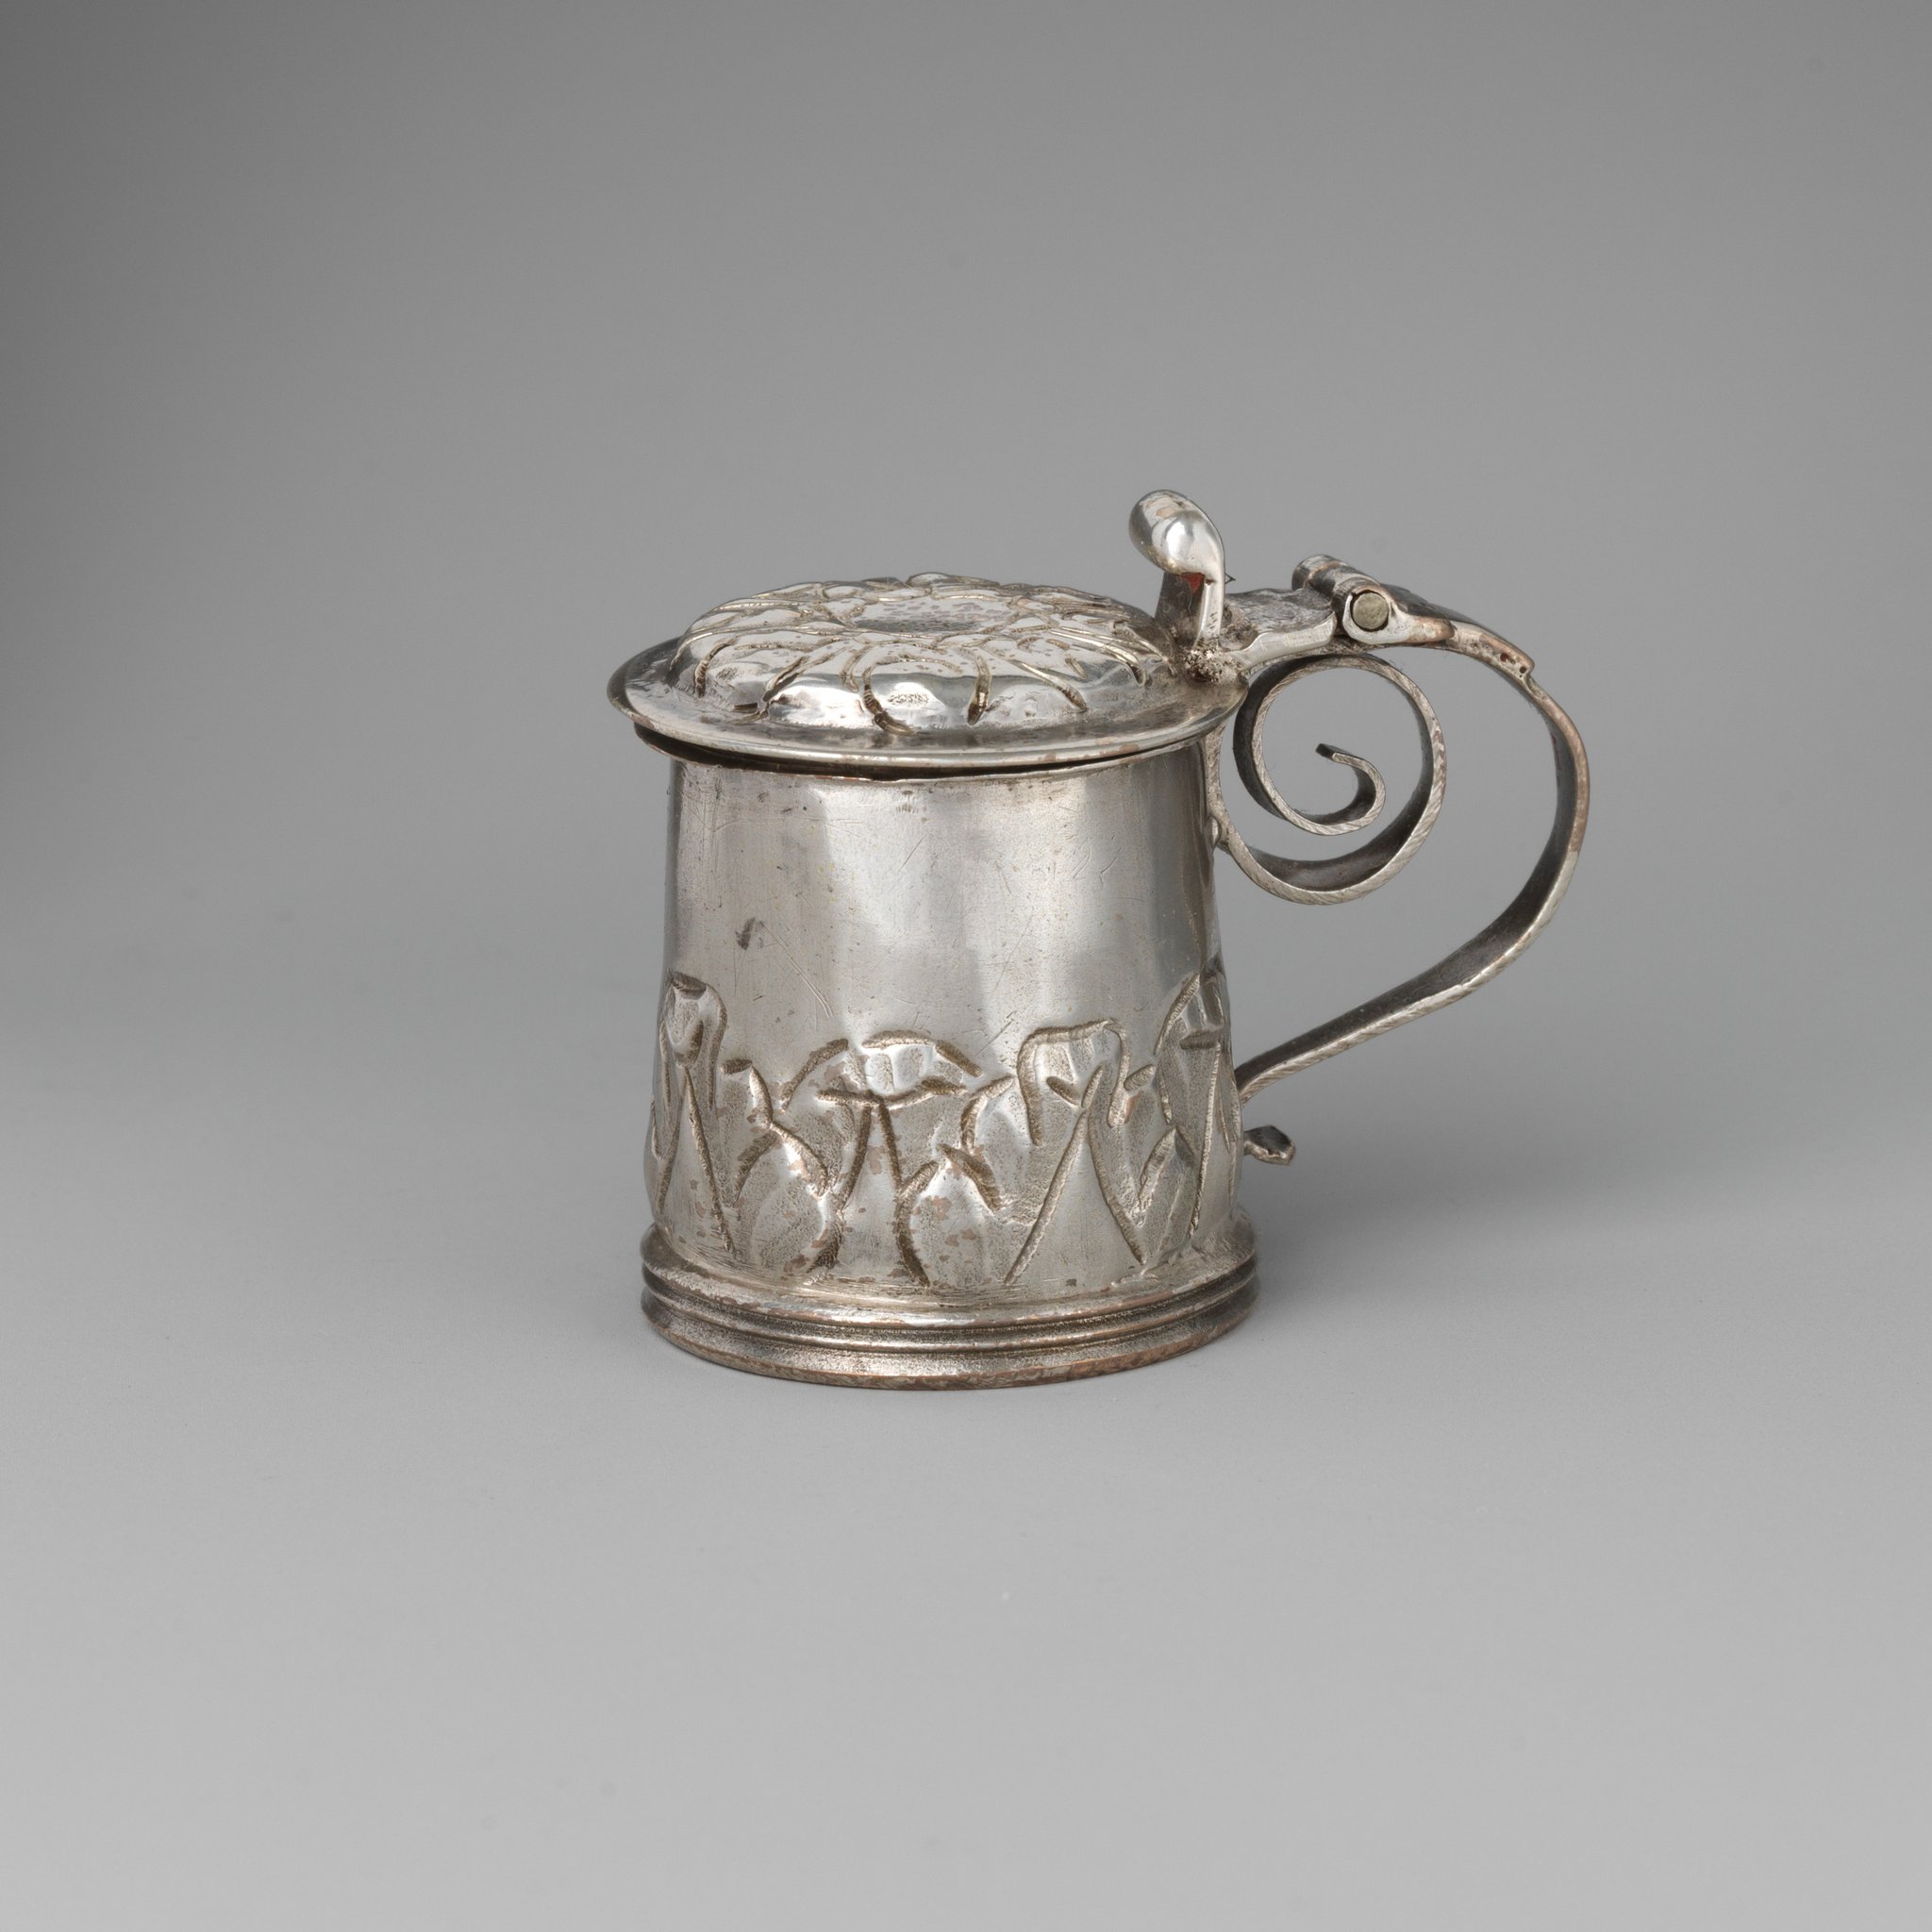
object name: tankard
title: Miniature tankard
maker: george manjoy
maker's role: maker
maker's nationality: british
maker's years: 1685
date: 1685-1686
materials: silver